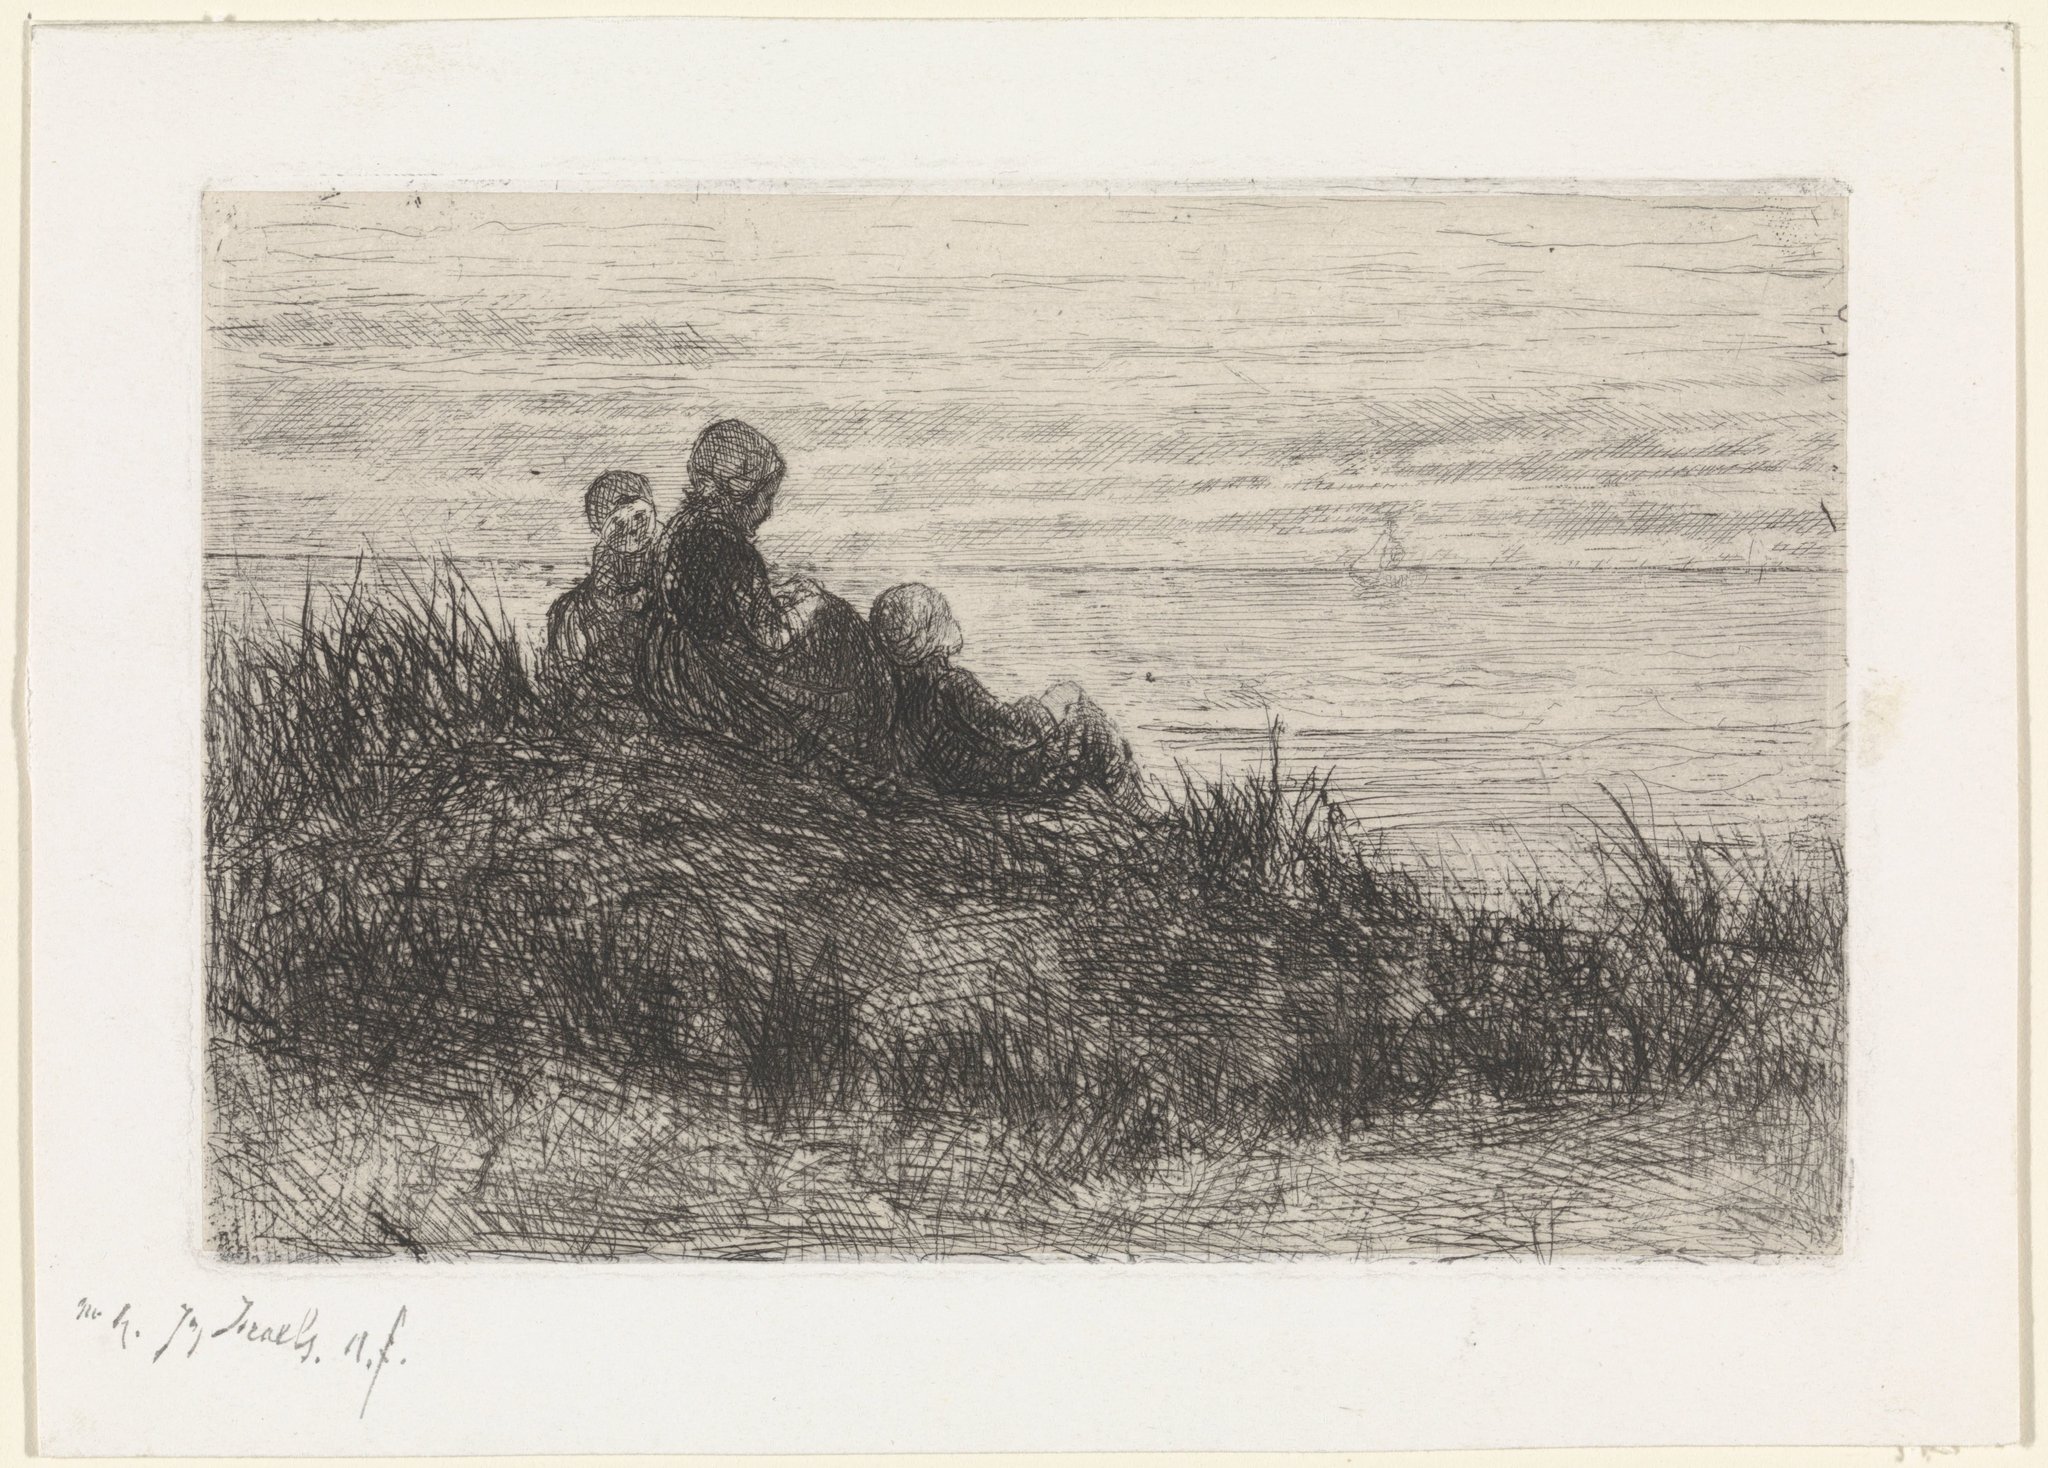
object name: print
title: Duinlandschap met moeder en kinderen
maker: jozef israëls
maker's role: draughtsman, painter, print maker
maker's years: 1824-1911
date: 1834-1878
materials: paper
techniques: etching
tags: dune coast (+ landscape with figures, staffage)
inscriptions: signature: ‘no. 4 joz israels a.f.’, collector's mark: Lugt 2228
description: Duinlandschap met aan linkerzijde moeder zittend met twee jonge kinderen. Rechts een boot op zee.